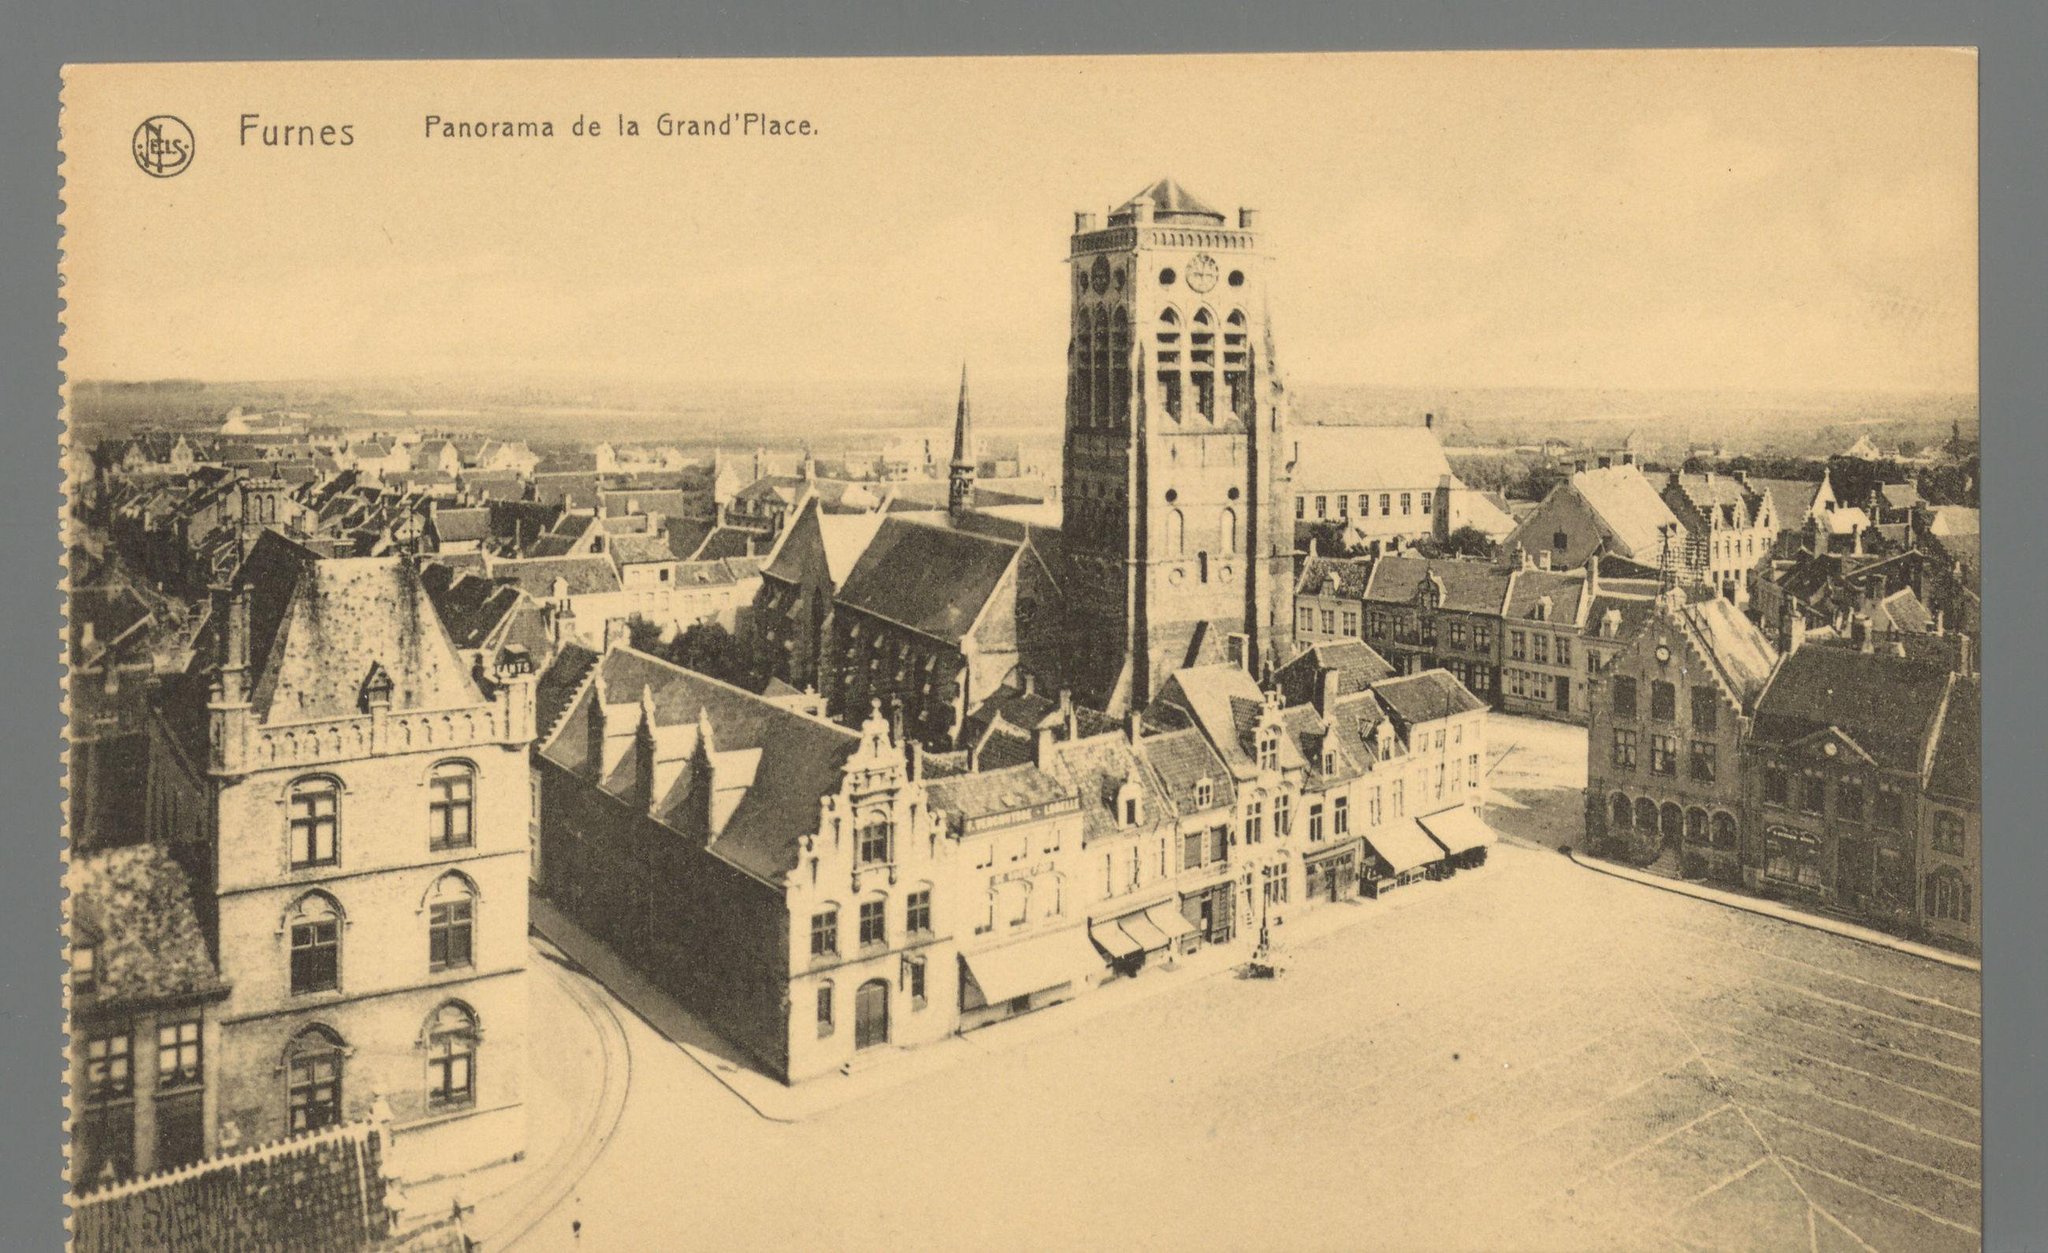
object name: ansichtkaart, prentbriefkaart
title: Furnes. Panorama de la Grand'Place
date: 1913-1918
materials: cardboard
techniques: photograph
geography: brussels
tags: square, place, circus, etc., roman catholic church